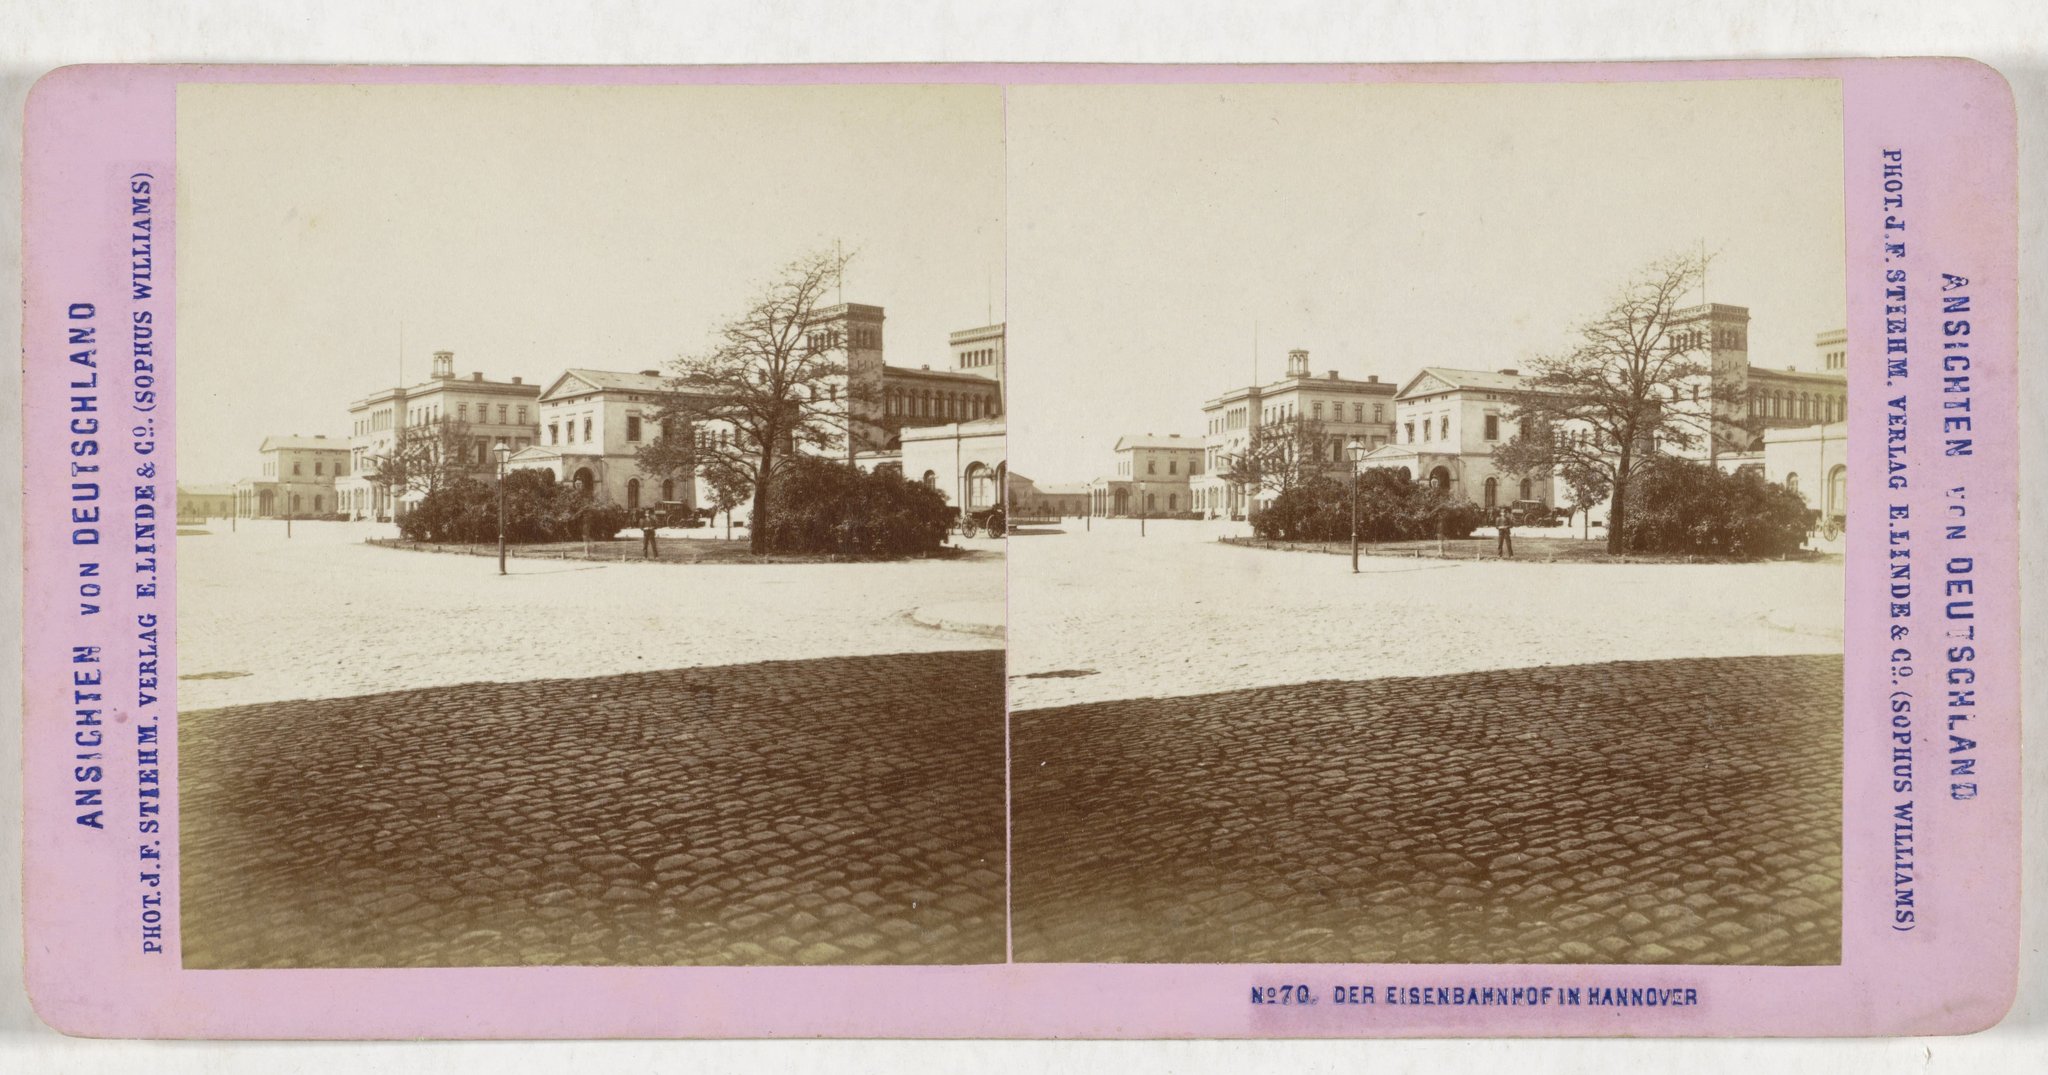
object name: stereograph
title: Treinstation van Hannover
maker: johann friedrich stiehm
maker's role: fotograaf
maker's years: 1826-1902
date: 1869-1872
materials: cardboard, paper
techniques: albumen print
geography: berlin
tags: square, place, circus, etc., station; shelter (railway, tramway)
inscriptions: number: ‘No 70.’